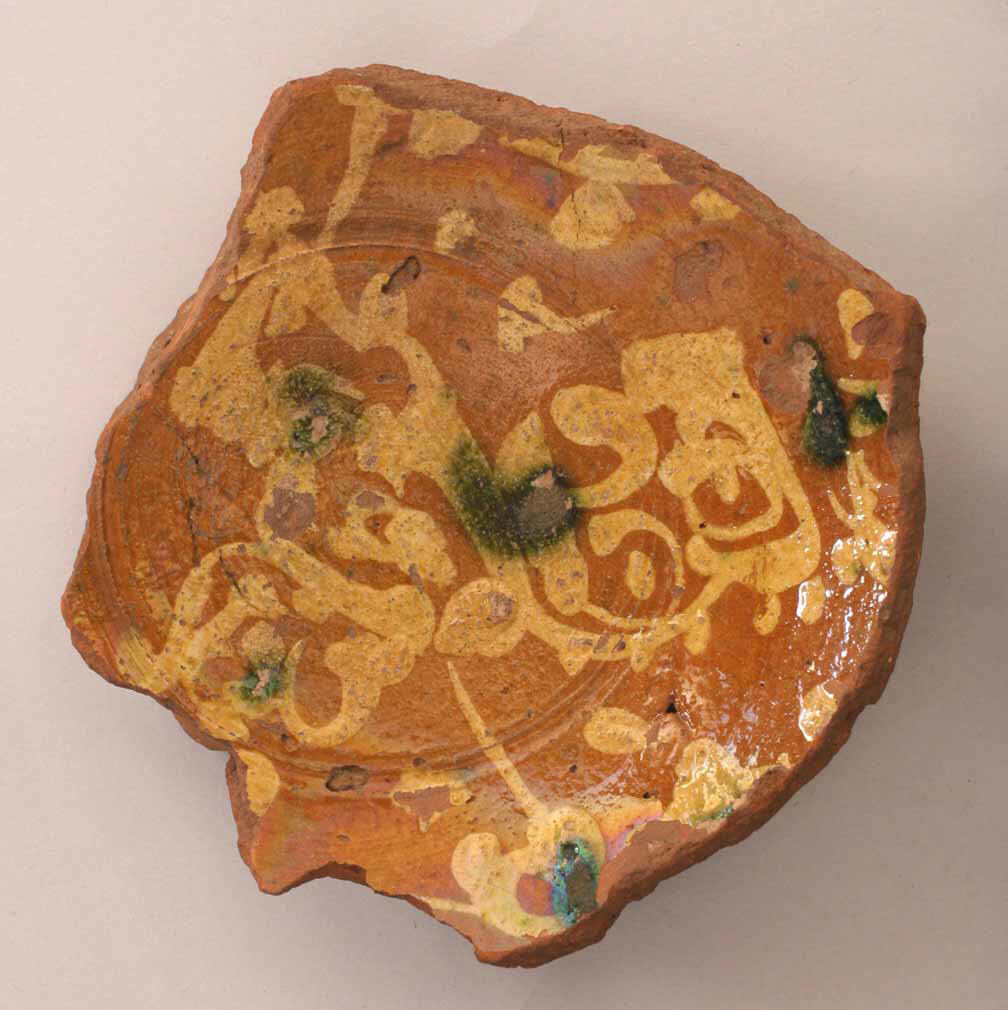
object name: fragment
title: Fragment of a Bowl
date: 1301-1500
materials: earthenware, glaze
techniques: painting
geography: egypt